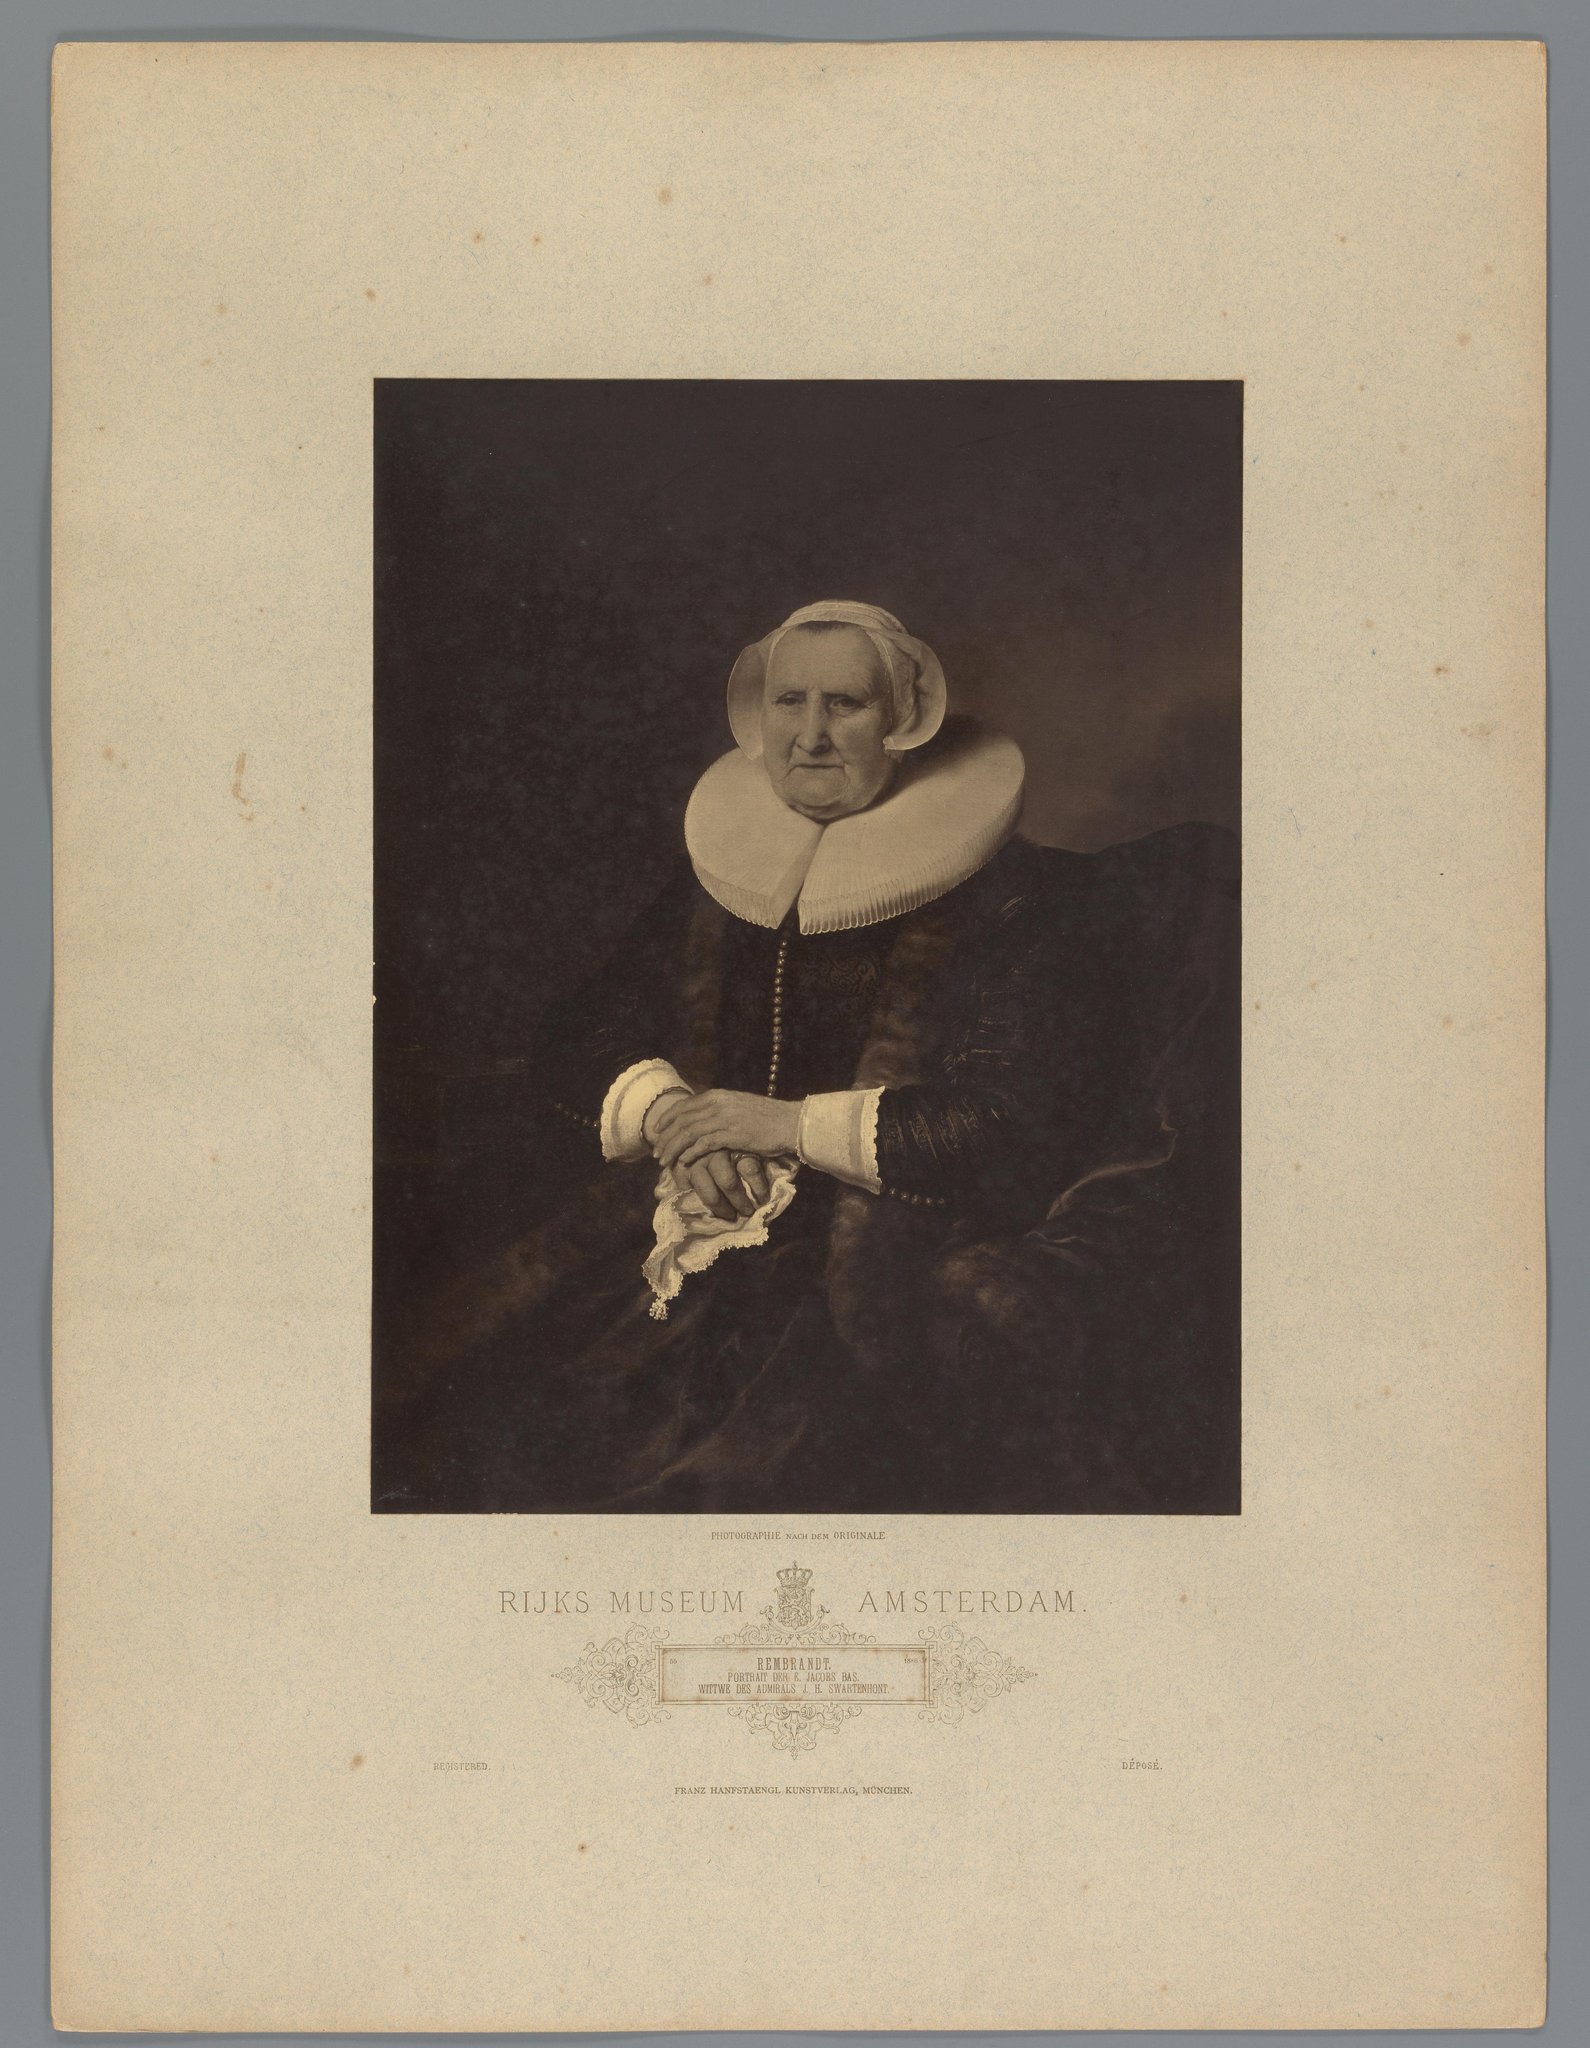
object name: page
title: Rembrandt. Portrait der E. Jacobs Bas. Witwe des Admirals J.H. Swartenhont.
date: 1886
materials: cardboard, paper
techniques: carbon print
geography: amsterdam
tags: historical persons - bb - woman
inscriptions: number: ‘55’, inscription: ‘Photographie nach dem Originale/ Rijks Museum Amsterdam/ Registered. Déposé.’